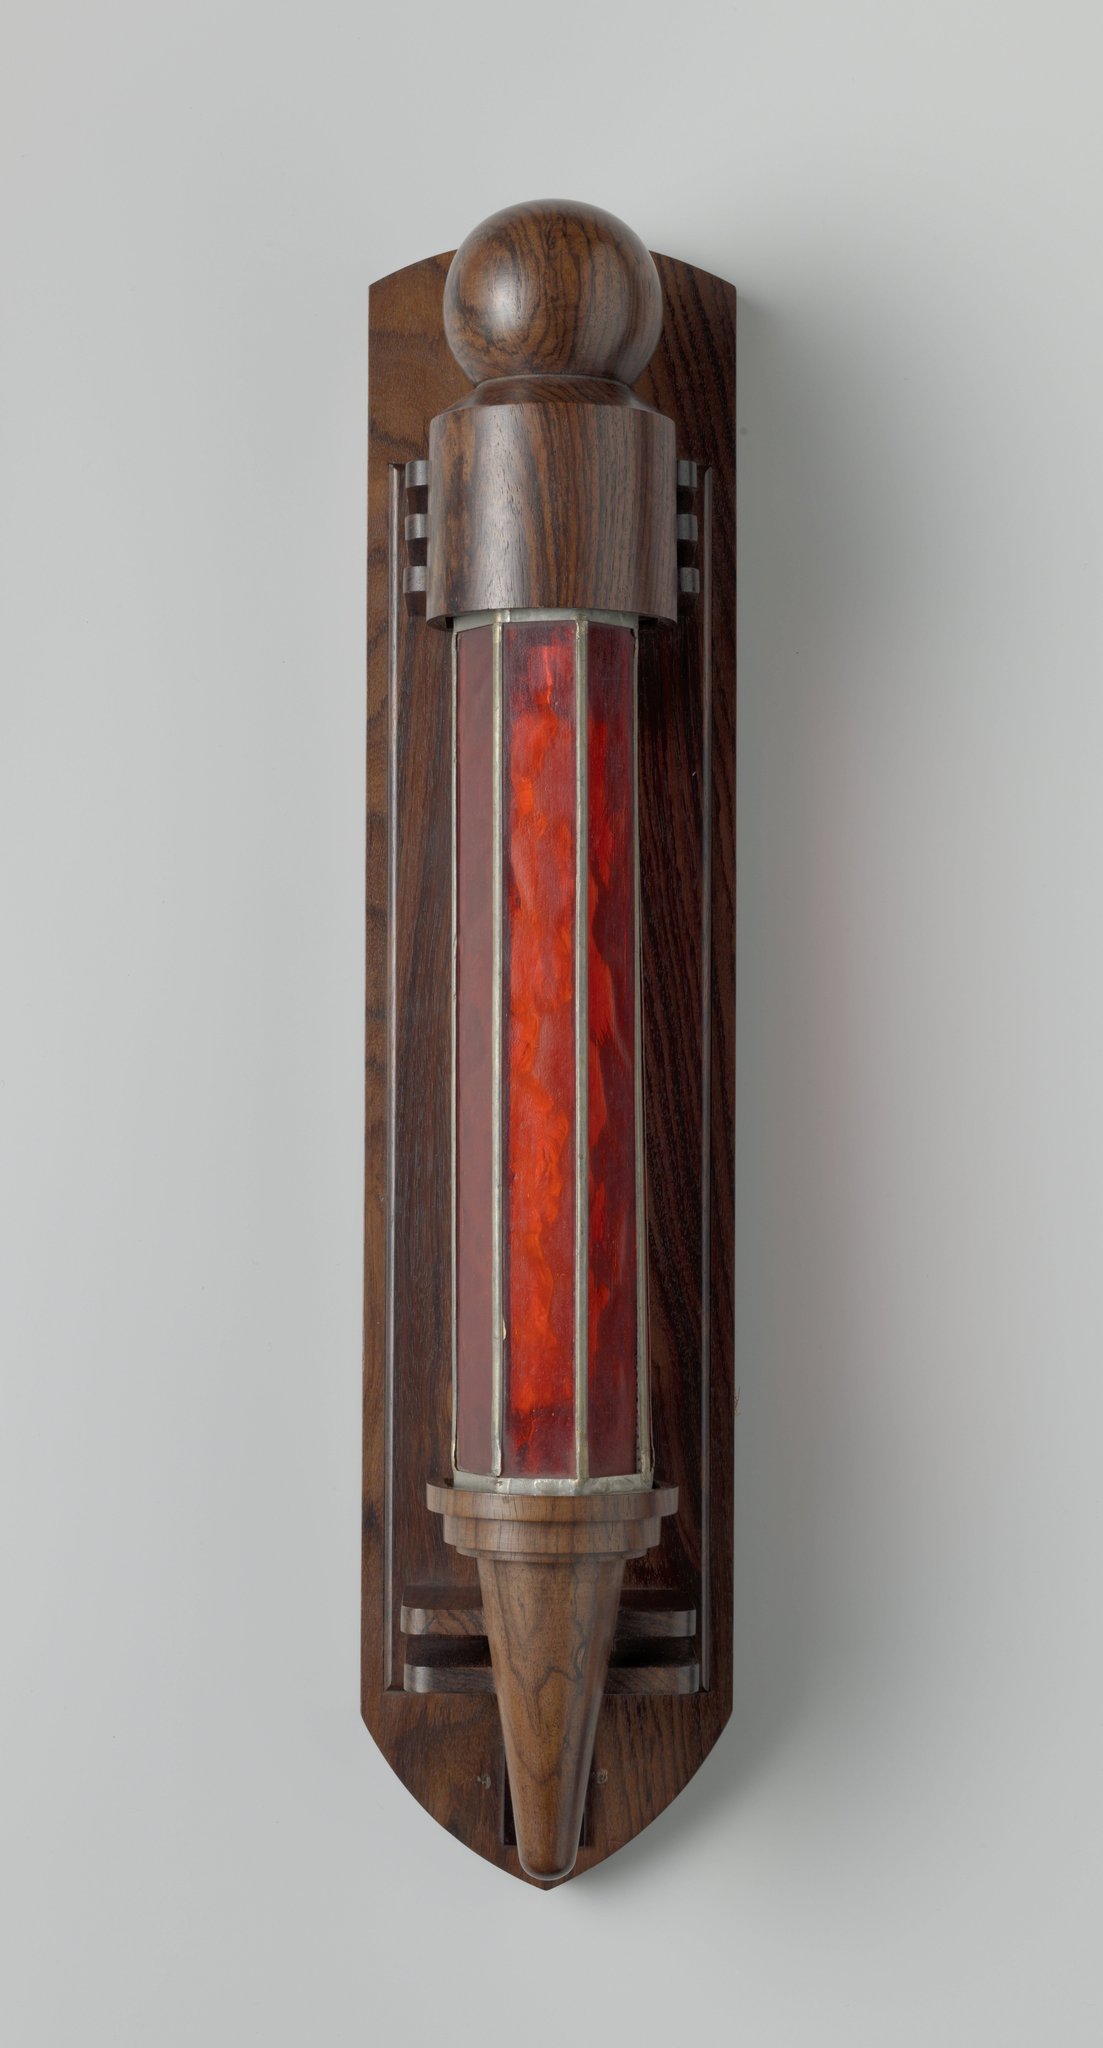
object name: lamp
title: Wandlamp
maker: ernst schubad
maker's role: interieurontwerper, meubelontwerper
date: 1910-1927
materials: glass, metal, wood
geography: netherlands